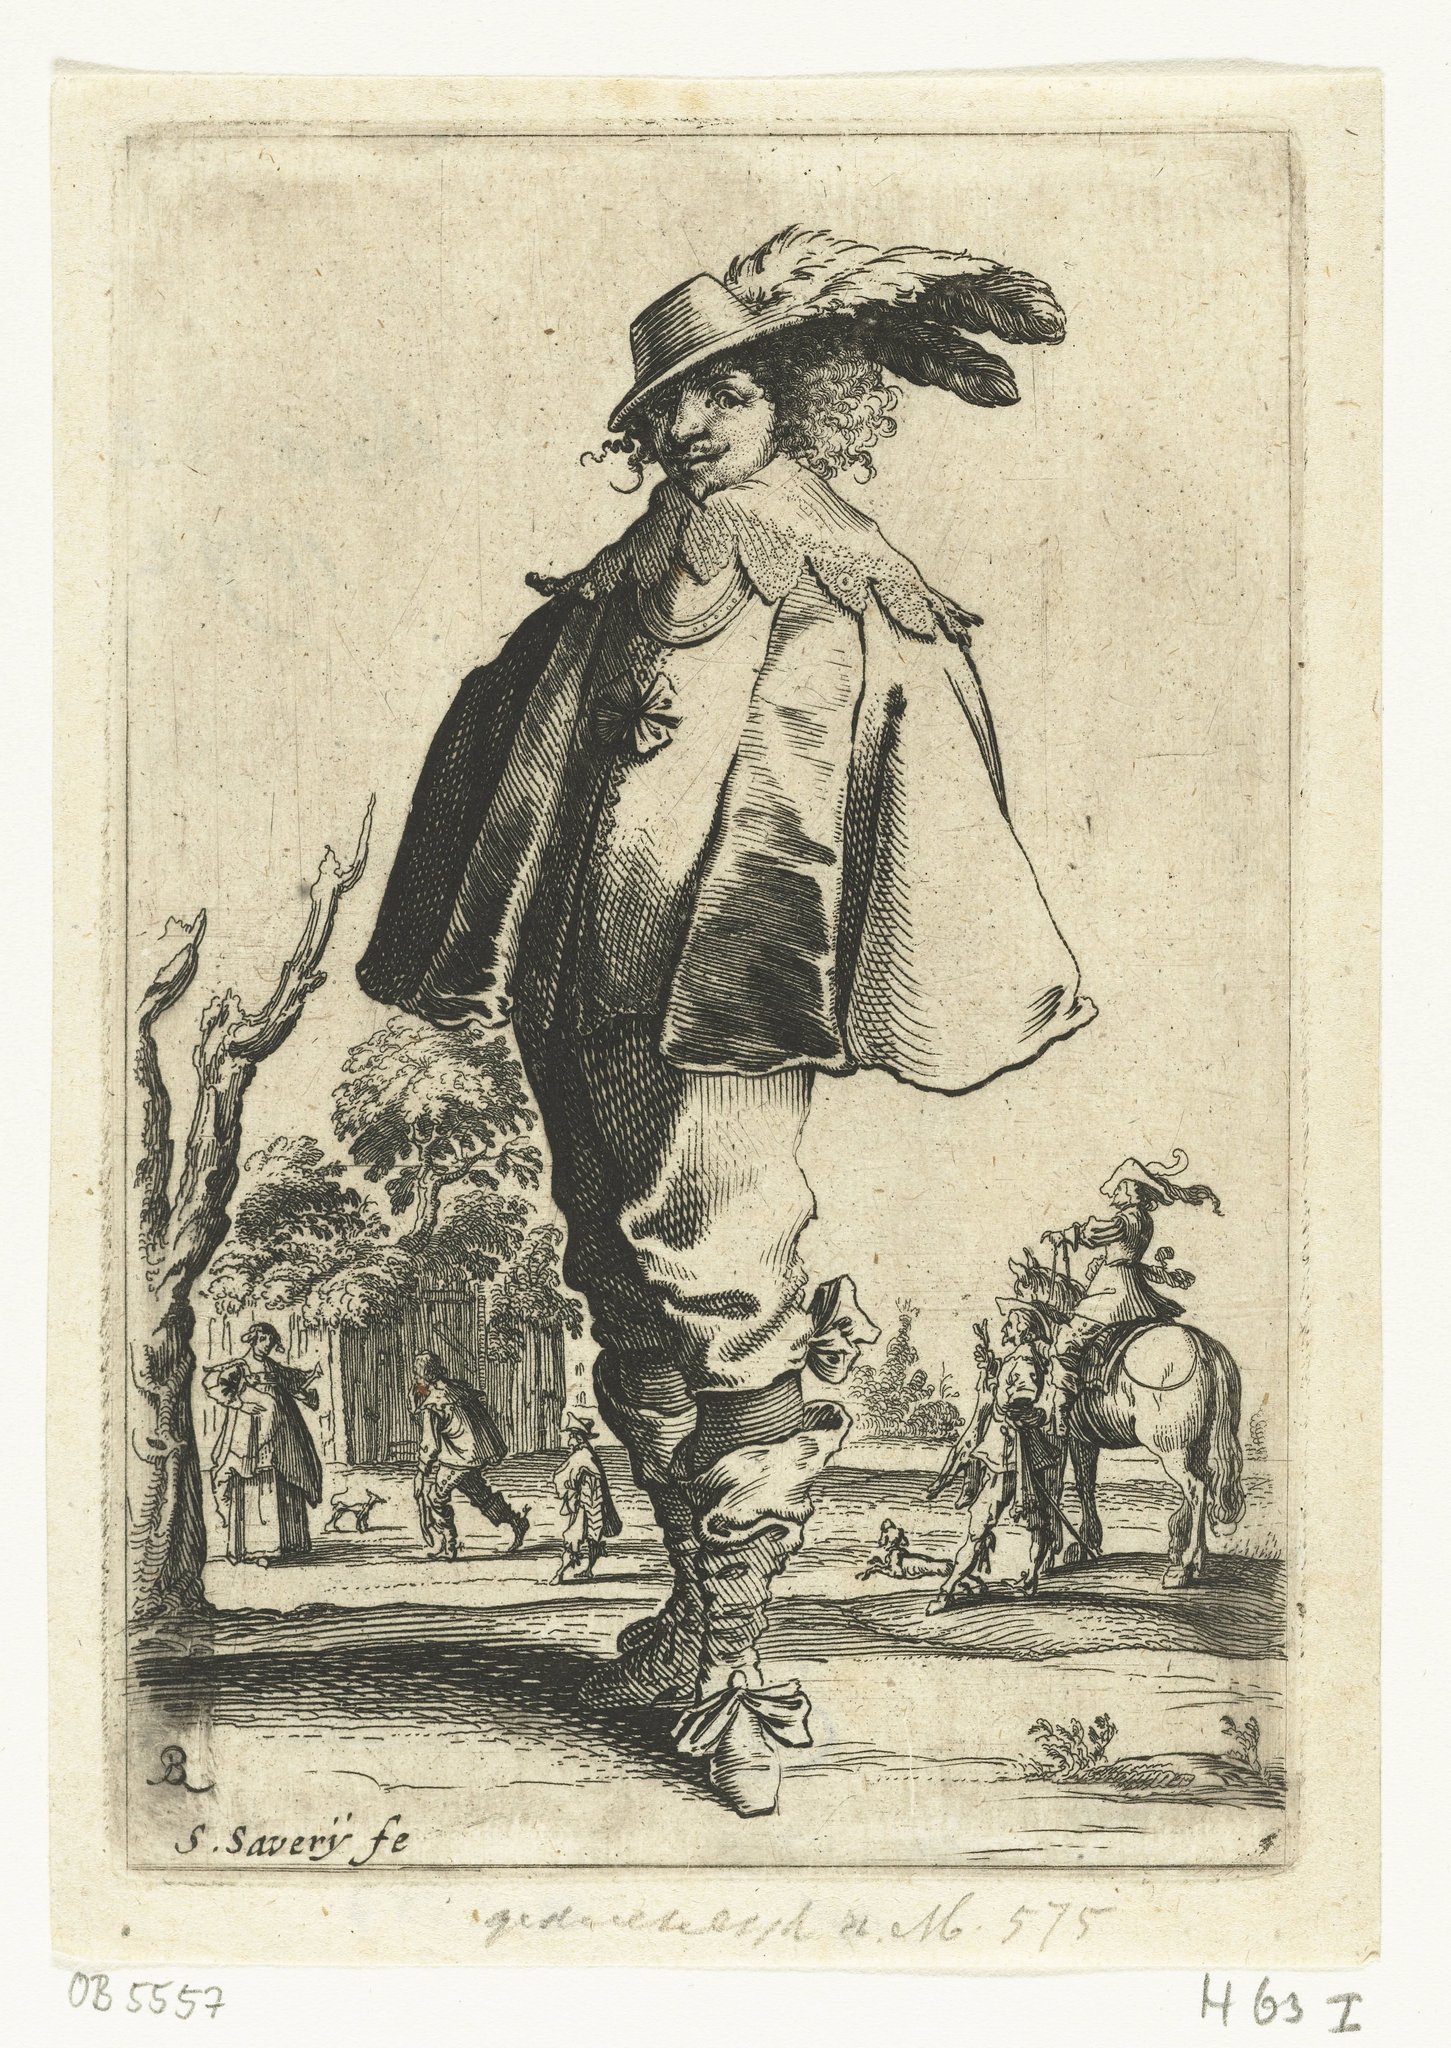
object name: costume print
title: Staande cavalier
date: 1630-1665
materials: paper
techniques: engraving, etching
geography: amsterdam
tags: warfare; military affairs (+ cavalry, horsemen), clothes, costume (+ men's clothes)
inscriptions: collector's mark: Lugt 2228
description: Cavalier, van voren gezien. Op de achtergrond een ruiter en enkele figuren. De prent maakt deel uit van een tiendelige serie met voorstellingen van gewapende officieren en soldaten, gekleed volgens de Nederlandse mode ca. 1625-1635.